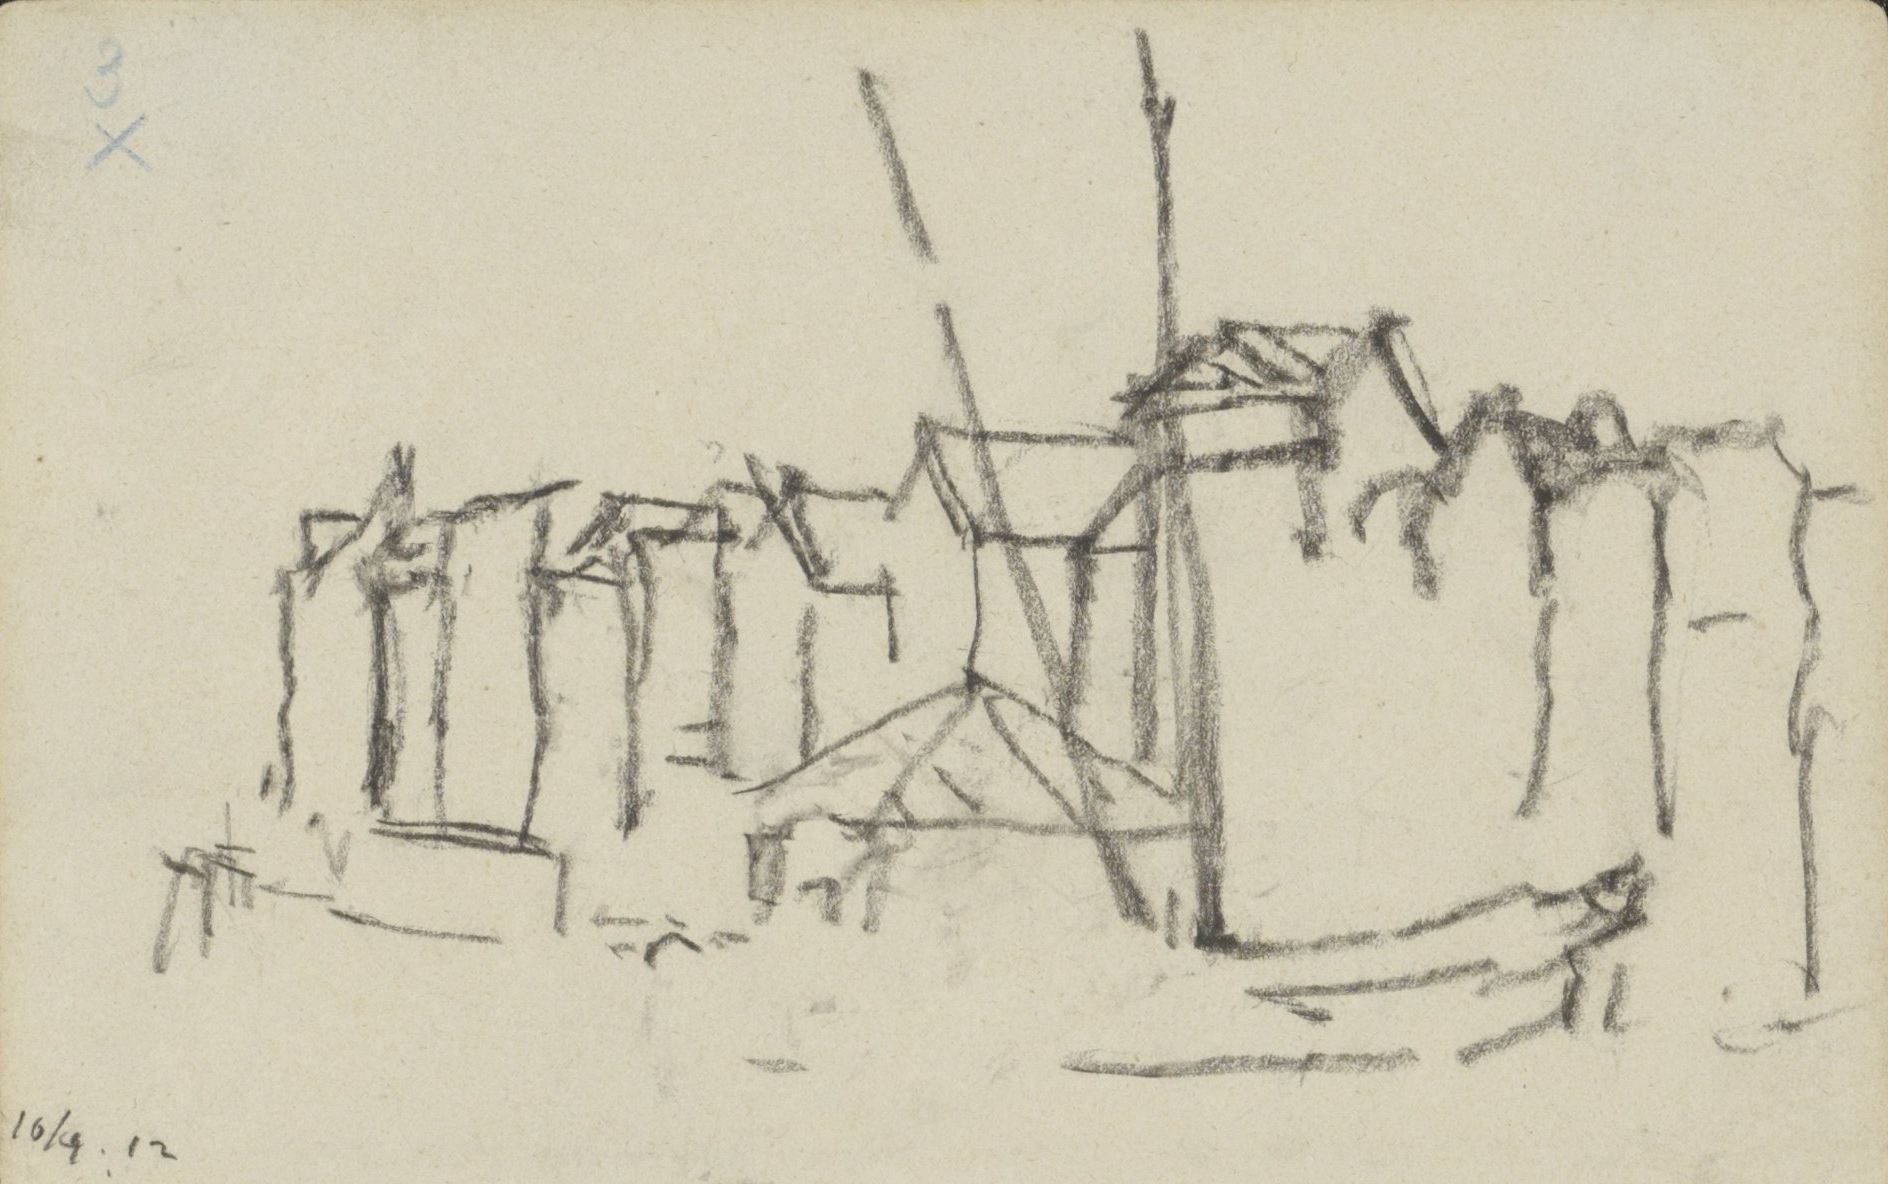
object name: drawing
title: Gezicht op het Damrak te Amsterdam, gezien naar de Warmoesstraat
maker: george hendrik breitner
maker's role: draughtsman, painter, print maker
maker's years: 1857-1923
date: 1912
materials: chalk, paper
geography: amsterdam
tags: urban housing, ships (in general), canals, waters (in city)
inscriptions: date: ‘16/4 12[?]’